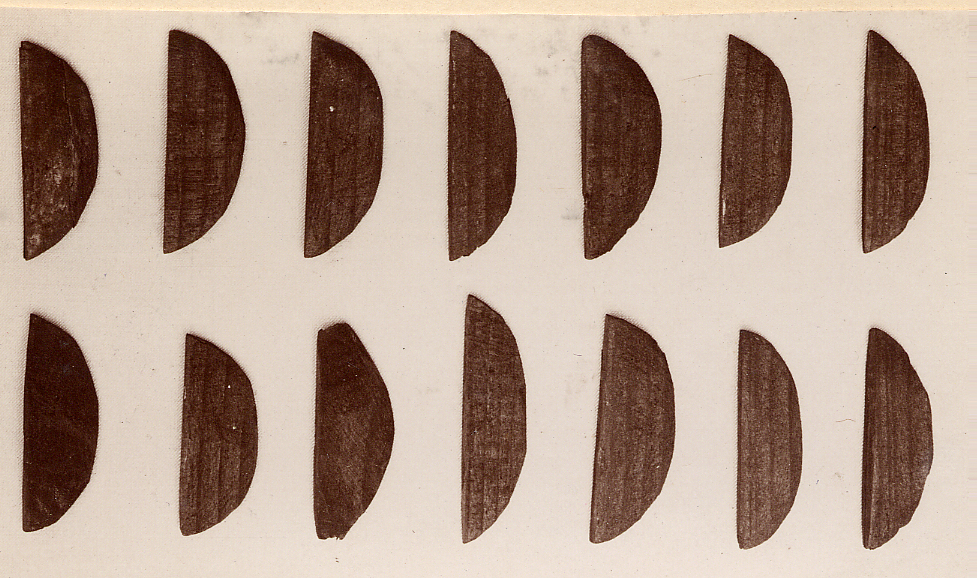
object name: wig ornament 14, hapiankhtifi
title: Wig ornaments of Hapiankhtifi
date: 1981-1802 BCE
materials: wood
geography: egypt